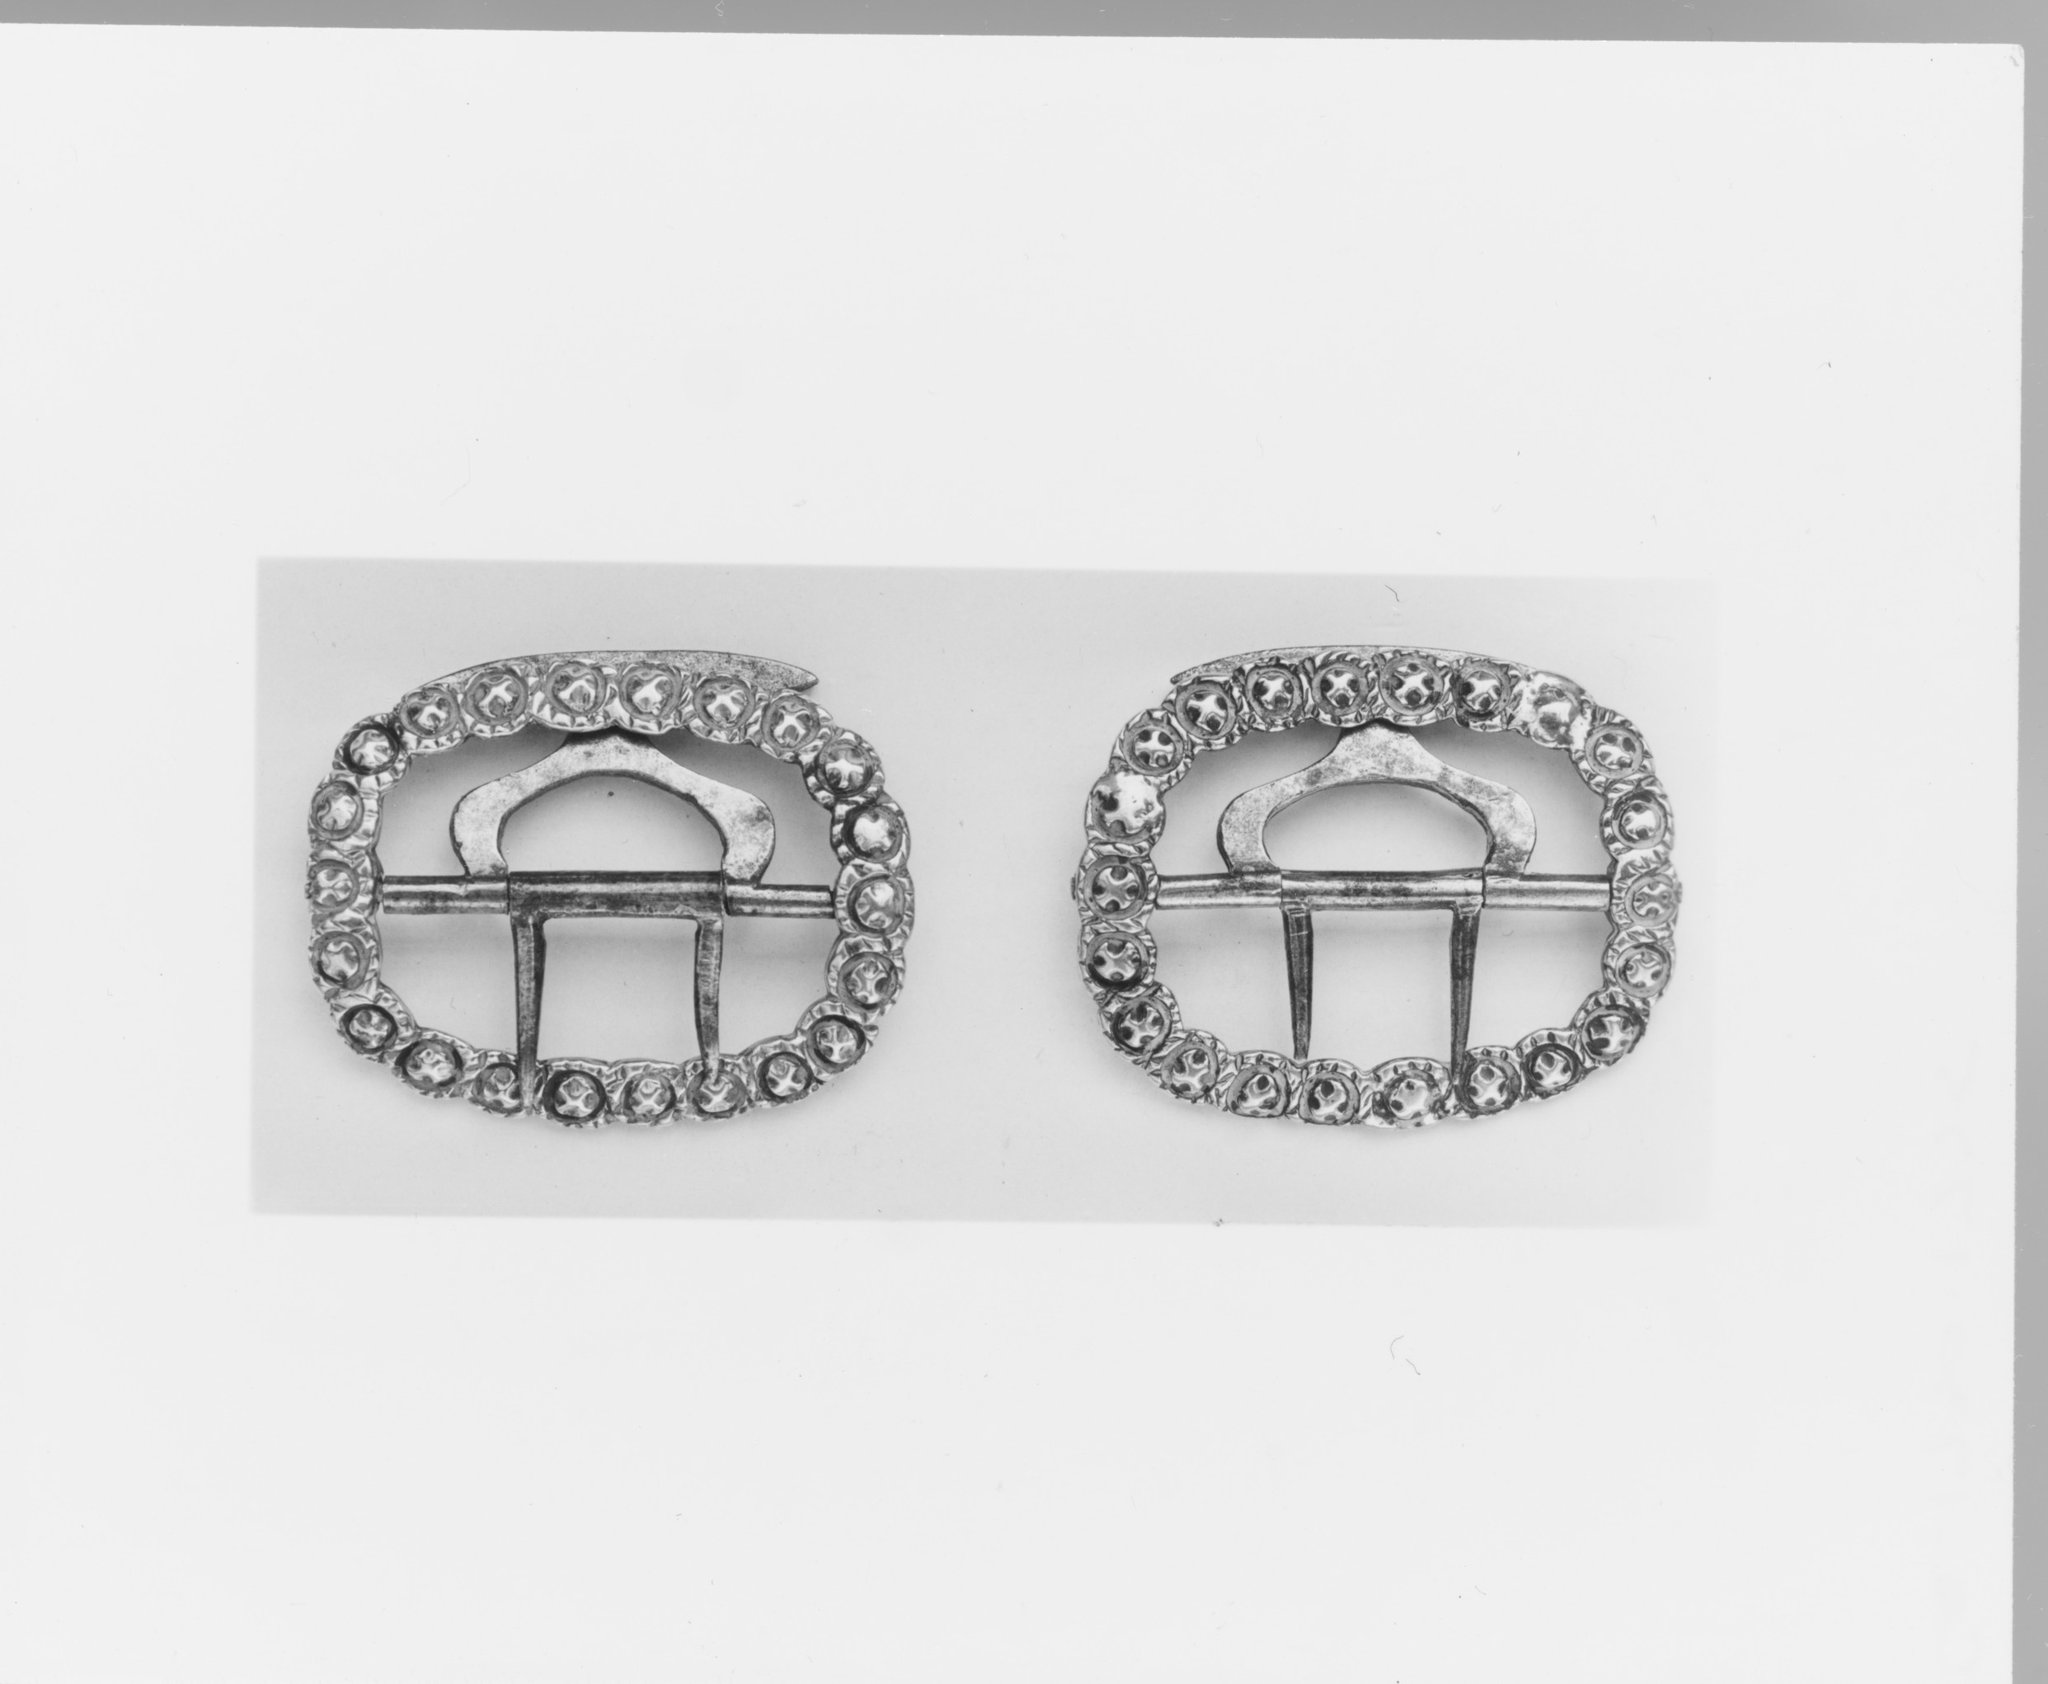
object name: buckle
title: Knee Buckle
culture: american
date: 1730-1775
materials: silver